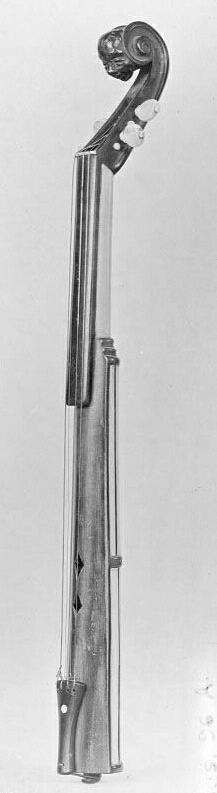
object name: pochette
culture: european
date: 1701-1800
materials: wood